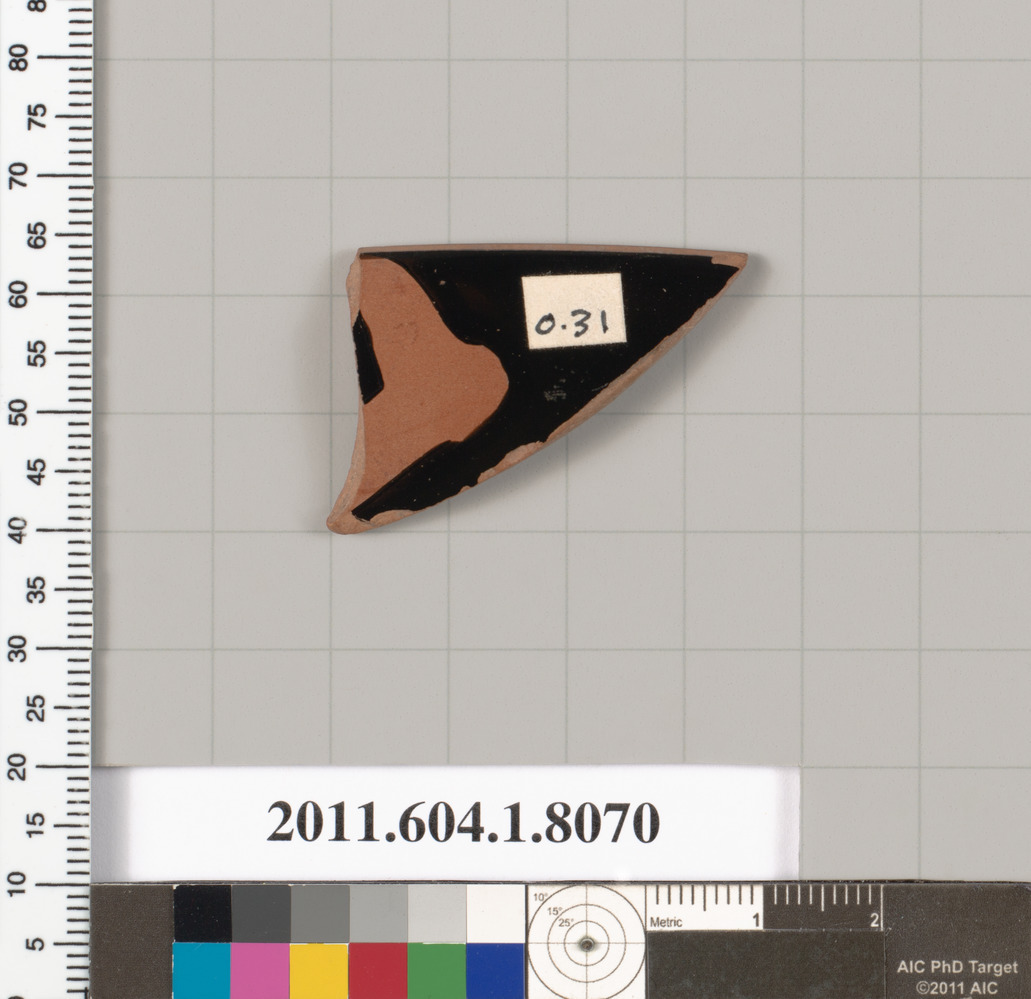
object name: kylix fragment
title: Terracotta rim fragment of a kylix (drinking cup)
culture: greek, attic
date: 510-500 BCE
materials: terracotta